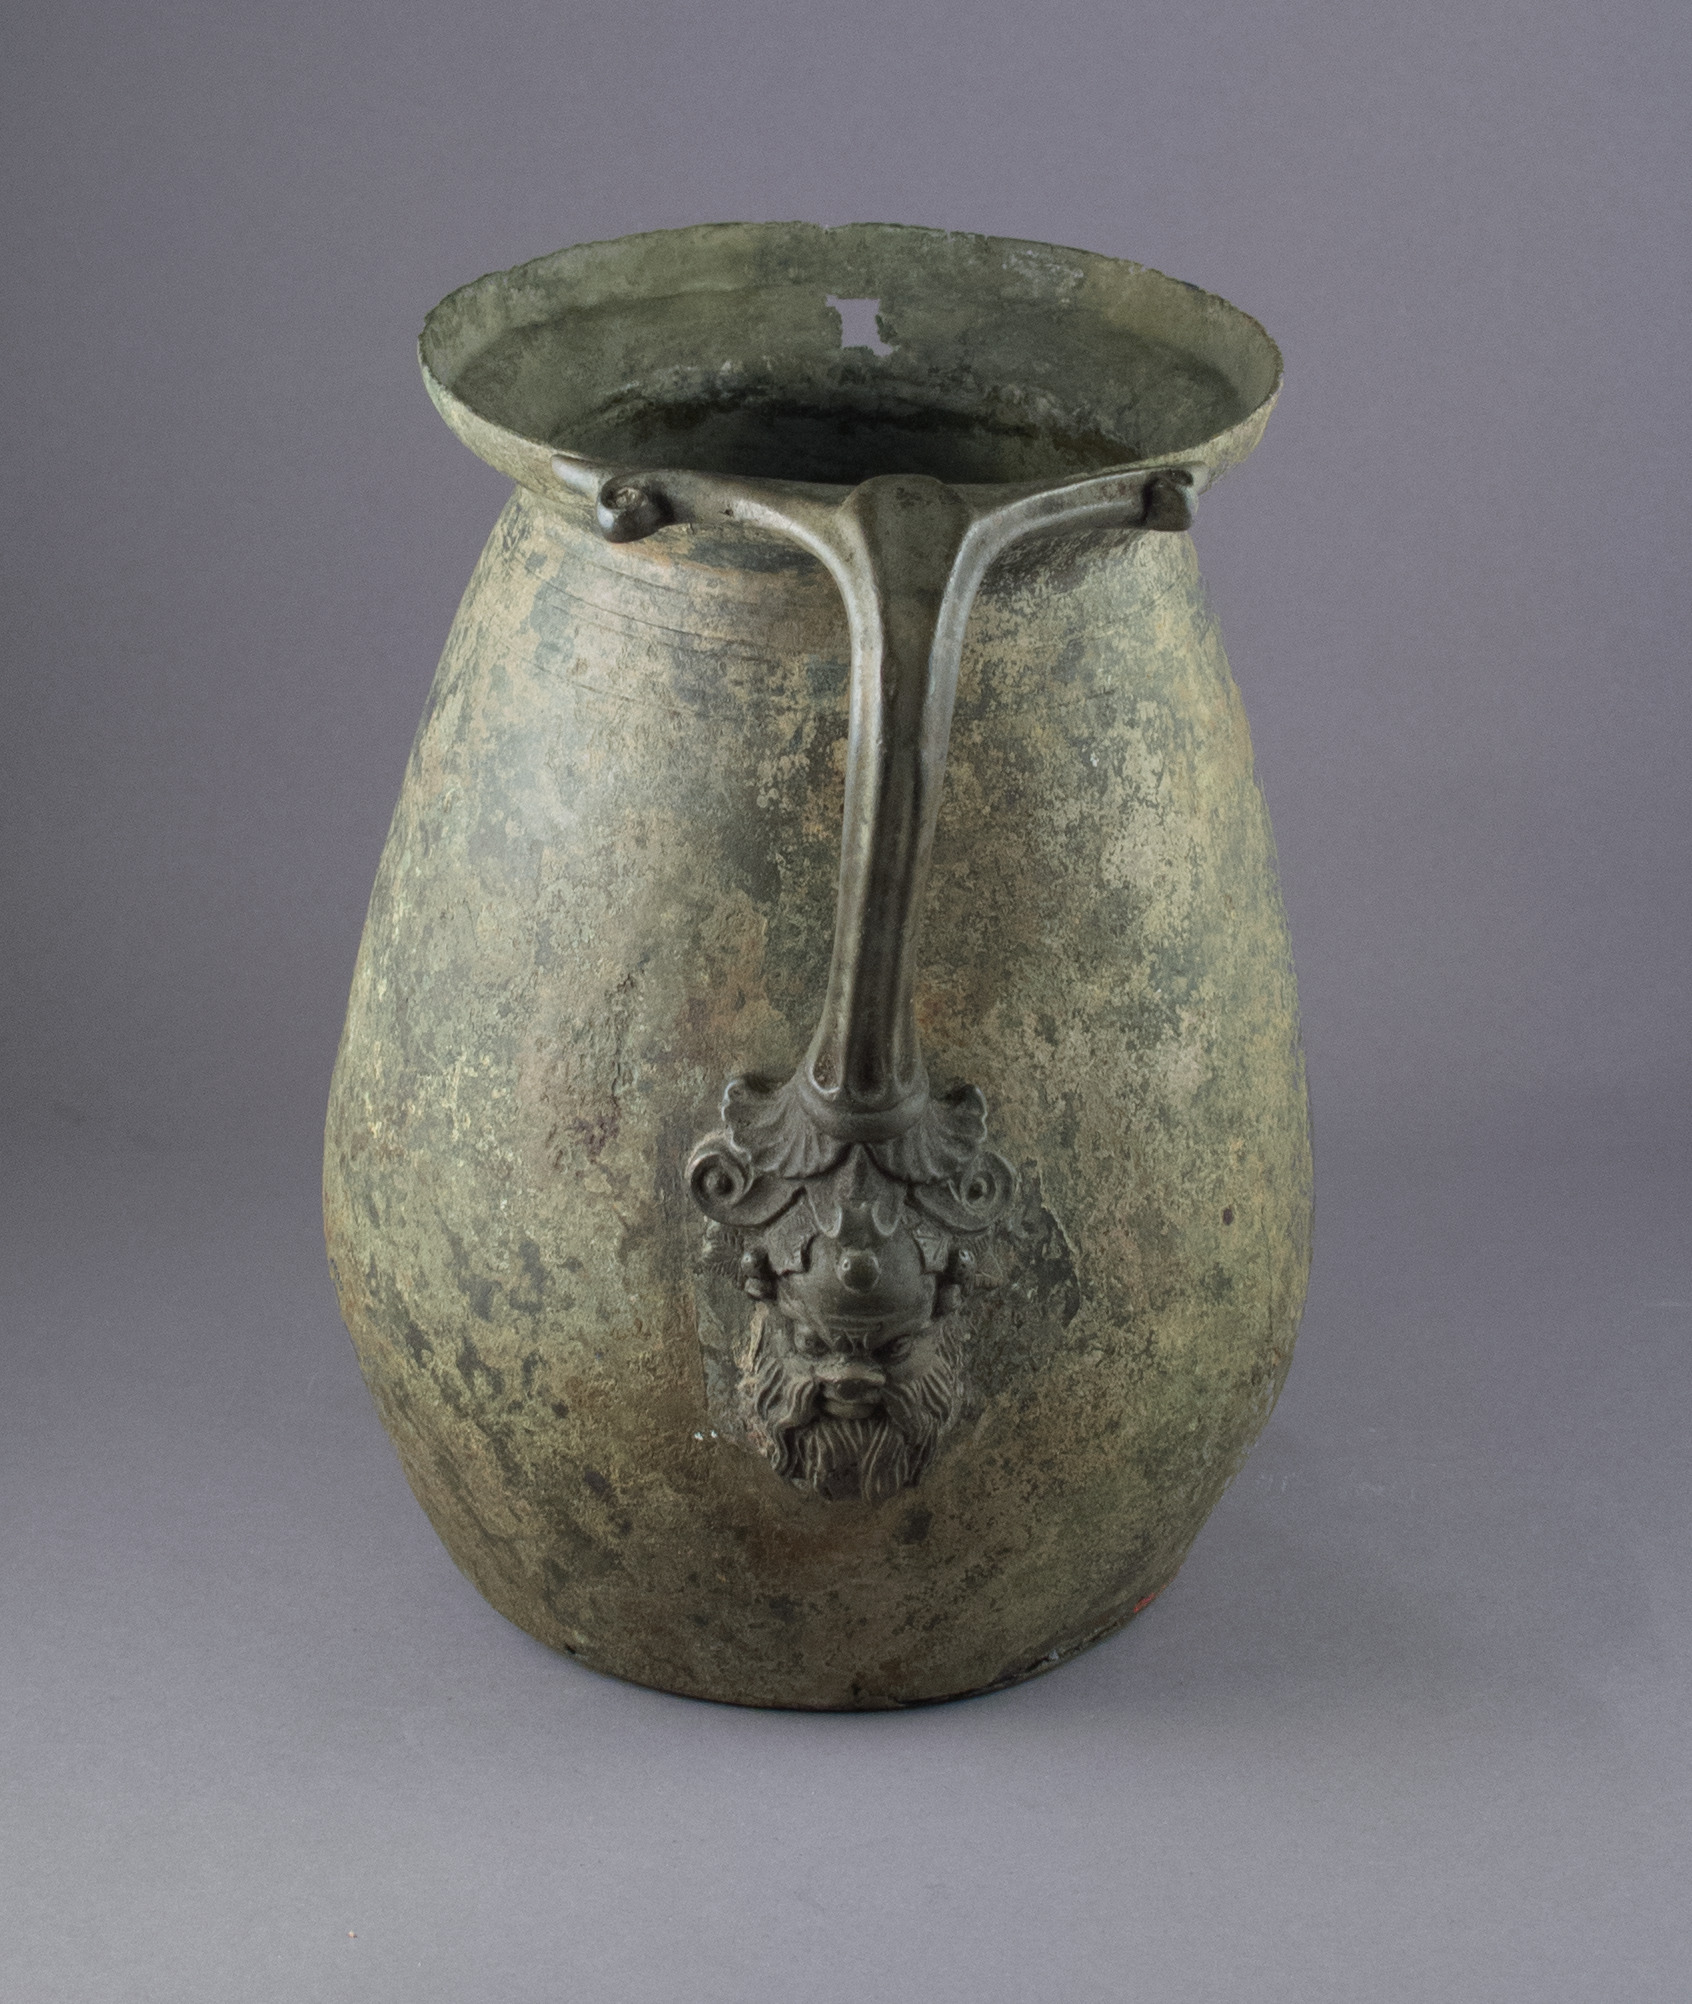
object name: jug with handle of silenos head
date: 7000 BCE-330 CE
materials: bronze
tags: silenus